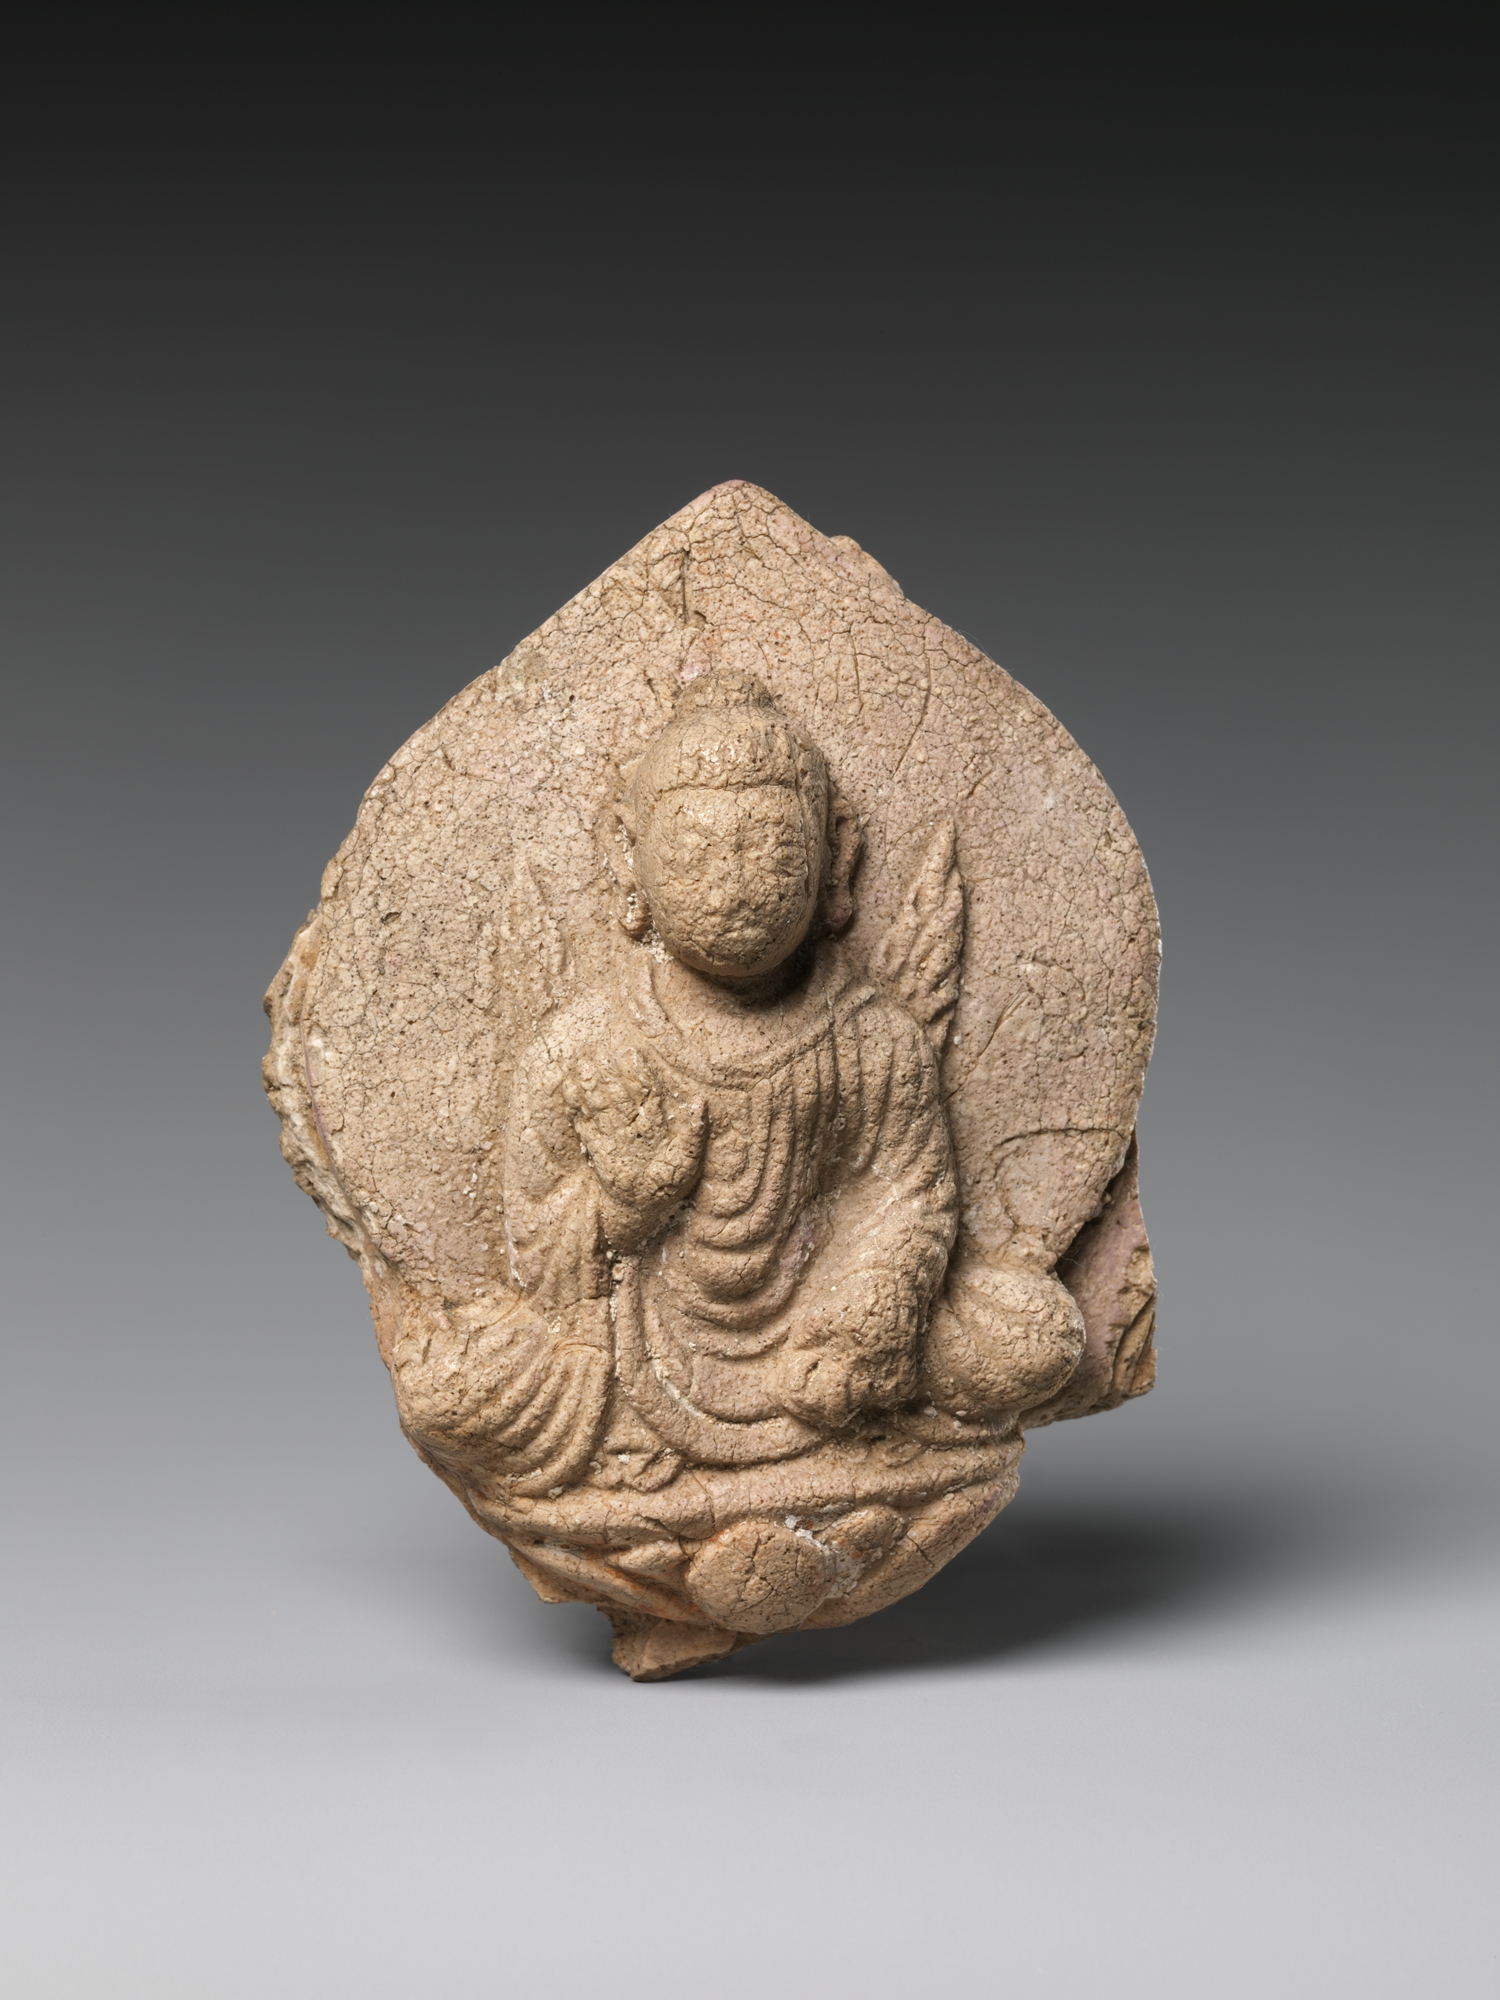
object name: relief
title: Seated Dipankara Buddha with Flaming Shoulders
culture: chinese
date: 501-700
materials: plaster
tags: buddhism,buddha